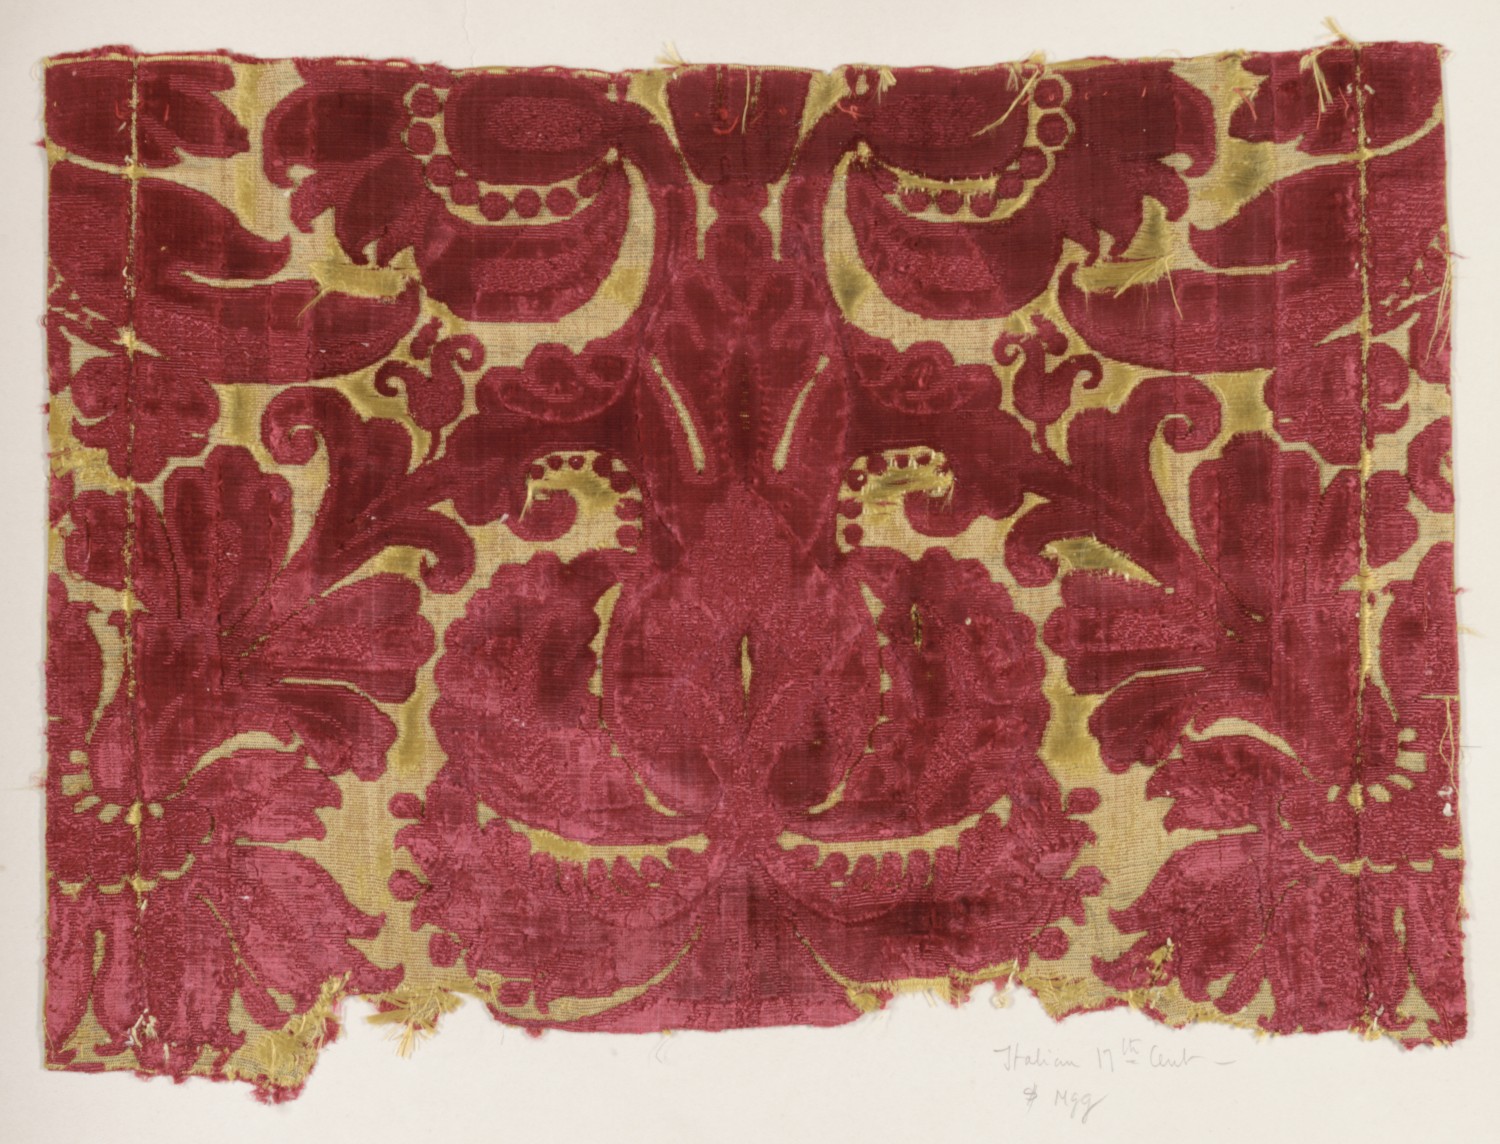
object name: fragment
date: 1601-1700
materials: metal thread, silk